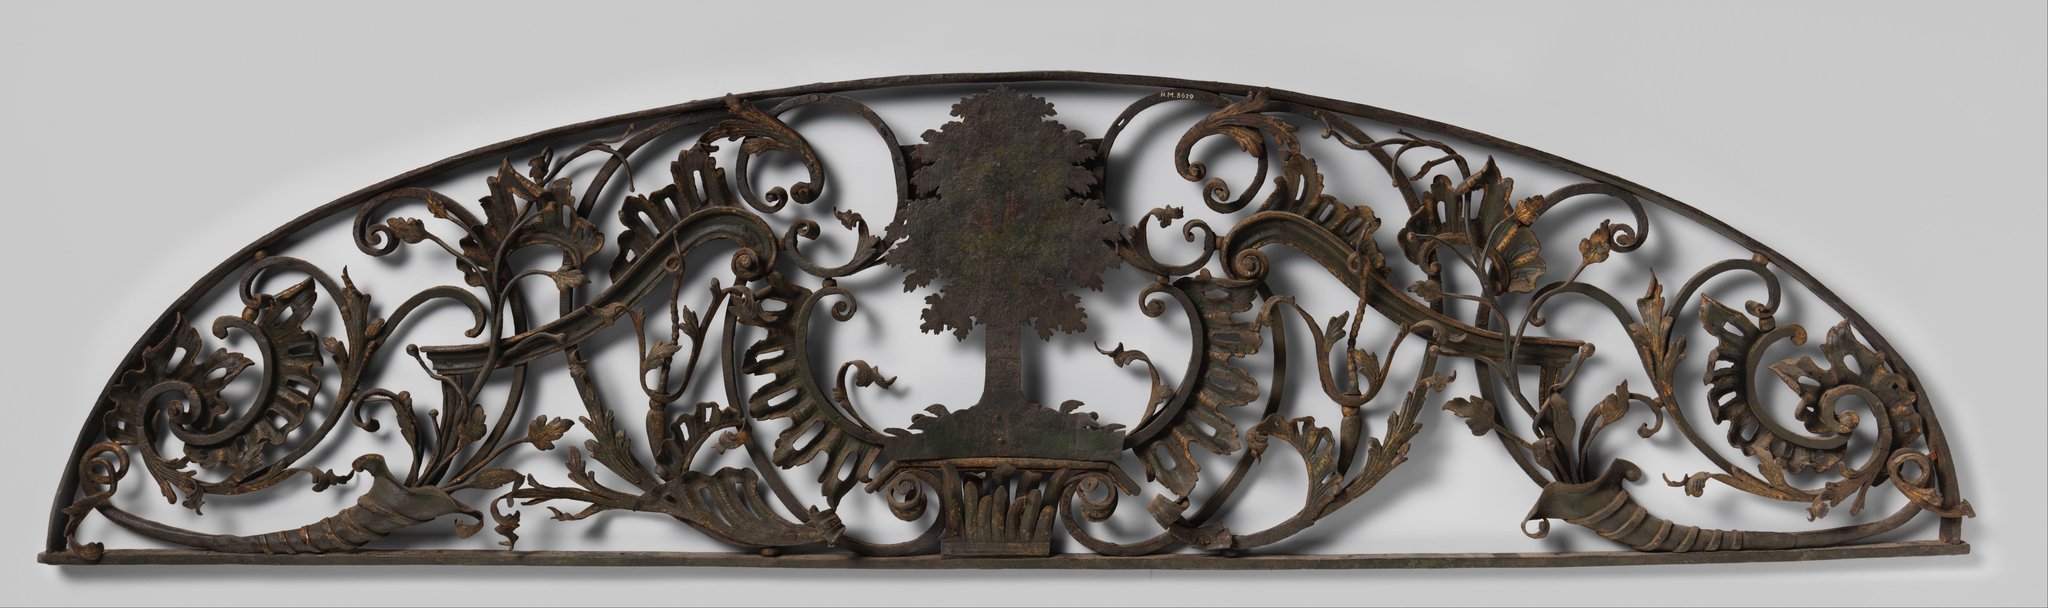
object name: transom window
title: Bovenlicht, versierd met boom en hoornen van overvloed.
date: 1400-1950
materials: iron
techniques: forging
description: Een gesmeed ijzeren bovenlicht. In het midden een boom, aan de zijden hoornen van overvloed, aangevuld met rijke ornamenten. Is geheel verguld geweest. Begin van de stijl van Lodewijk XIV.